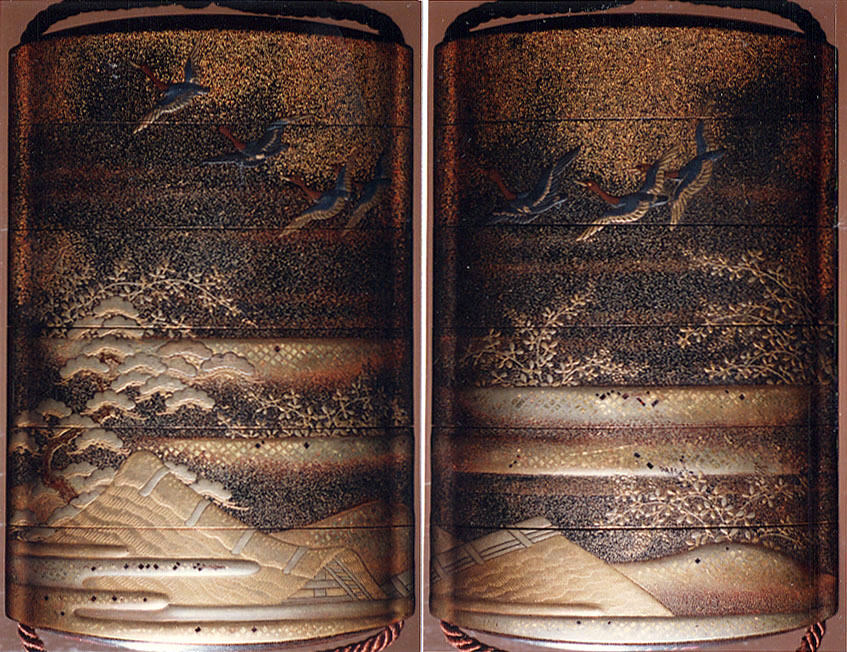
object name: inrō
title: Case (Inrō) with Design of Geese in Flight above Thatched Roofs and Pines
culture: japanese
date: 1801-1900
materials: gold, lacquer, silver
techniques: fundame, hiramakie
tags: birds,roofs,trees